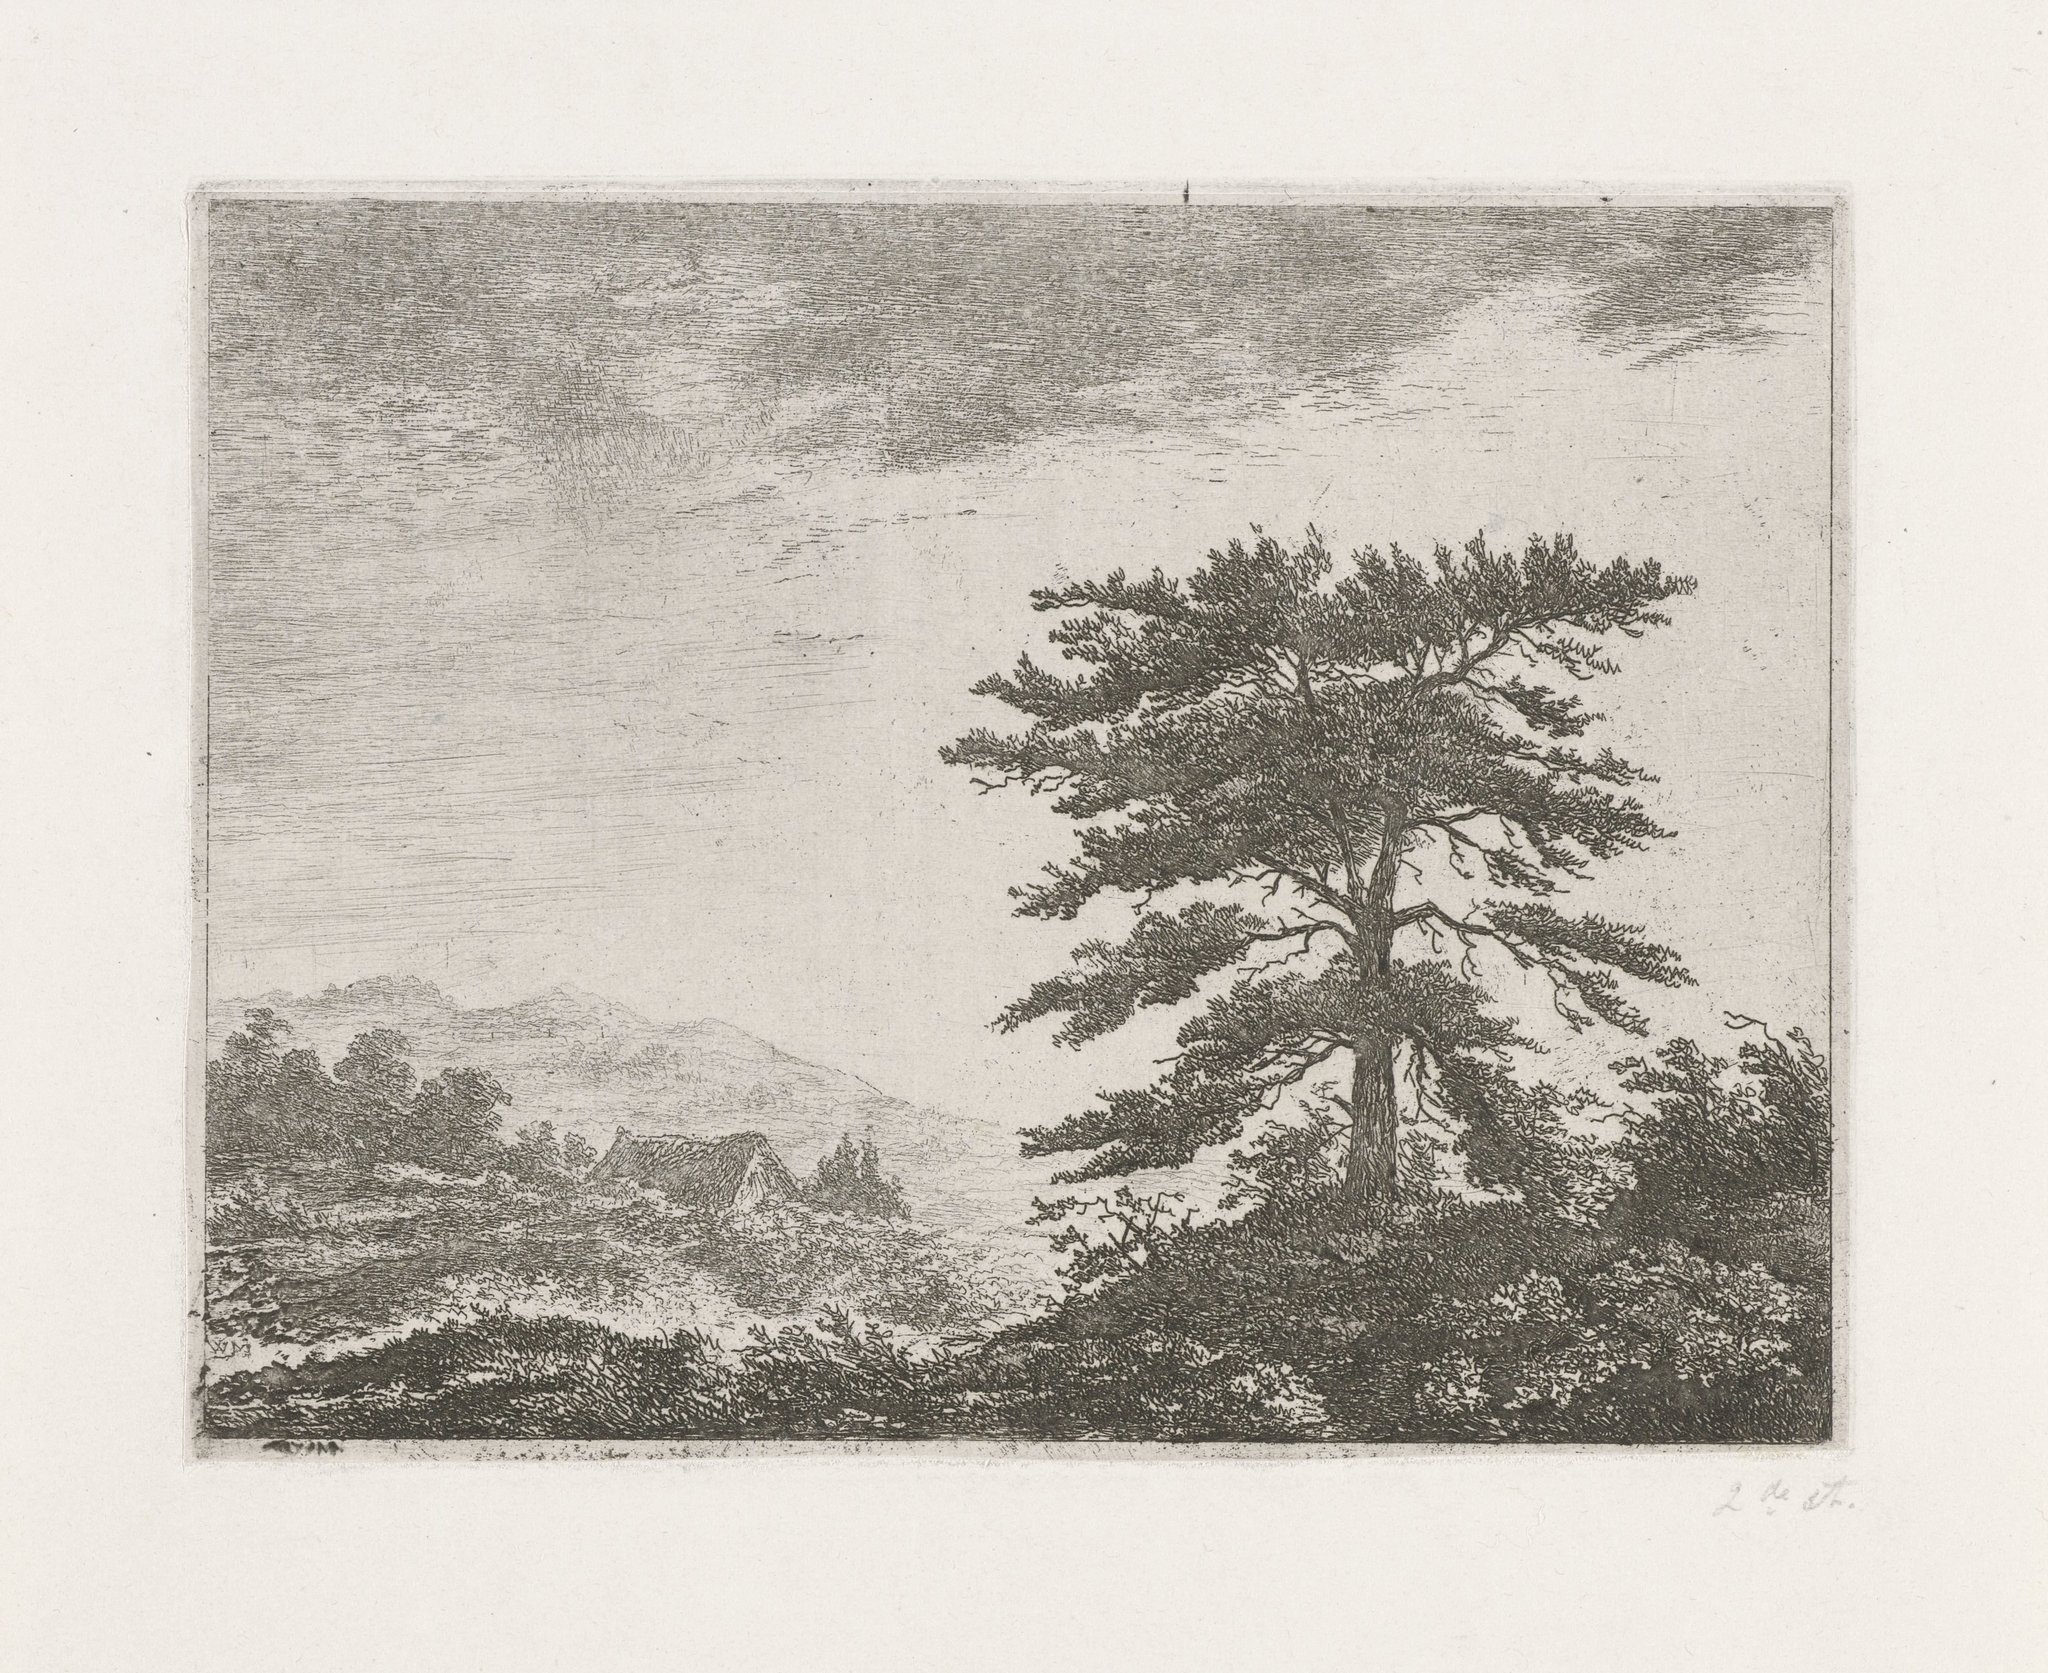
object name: print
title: Boom in een heidelandschap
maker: christiaan wilhelmus moorrees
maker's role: draughtsman, print maker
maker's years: 1801-1867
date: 1811-1867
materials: paper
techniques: etching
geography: netherlands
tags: trees, shrubs: broom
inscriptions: collector's mark: Lugt 2228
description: Een boom in een glooiend heidelandschap. Links het dak van een huis.